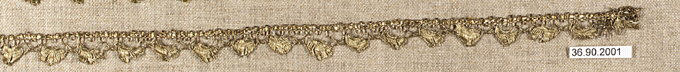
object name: piece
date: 1801-1900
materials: metal thread, silk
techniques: lace